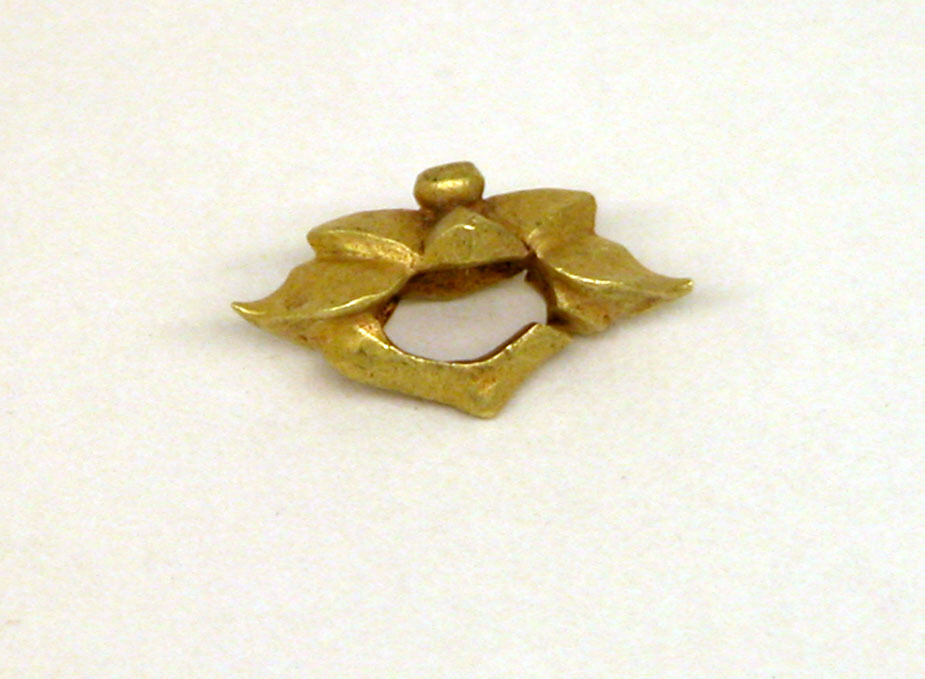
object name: ear ornament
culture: indonesian, javanese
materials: gold